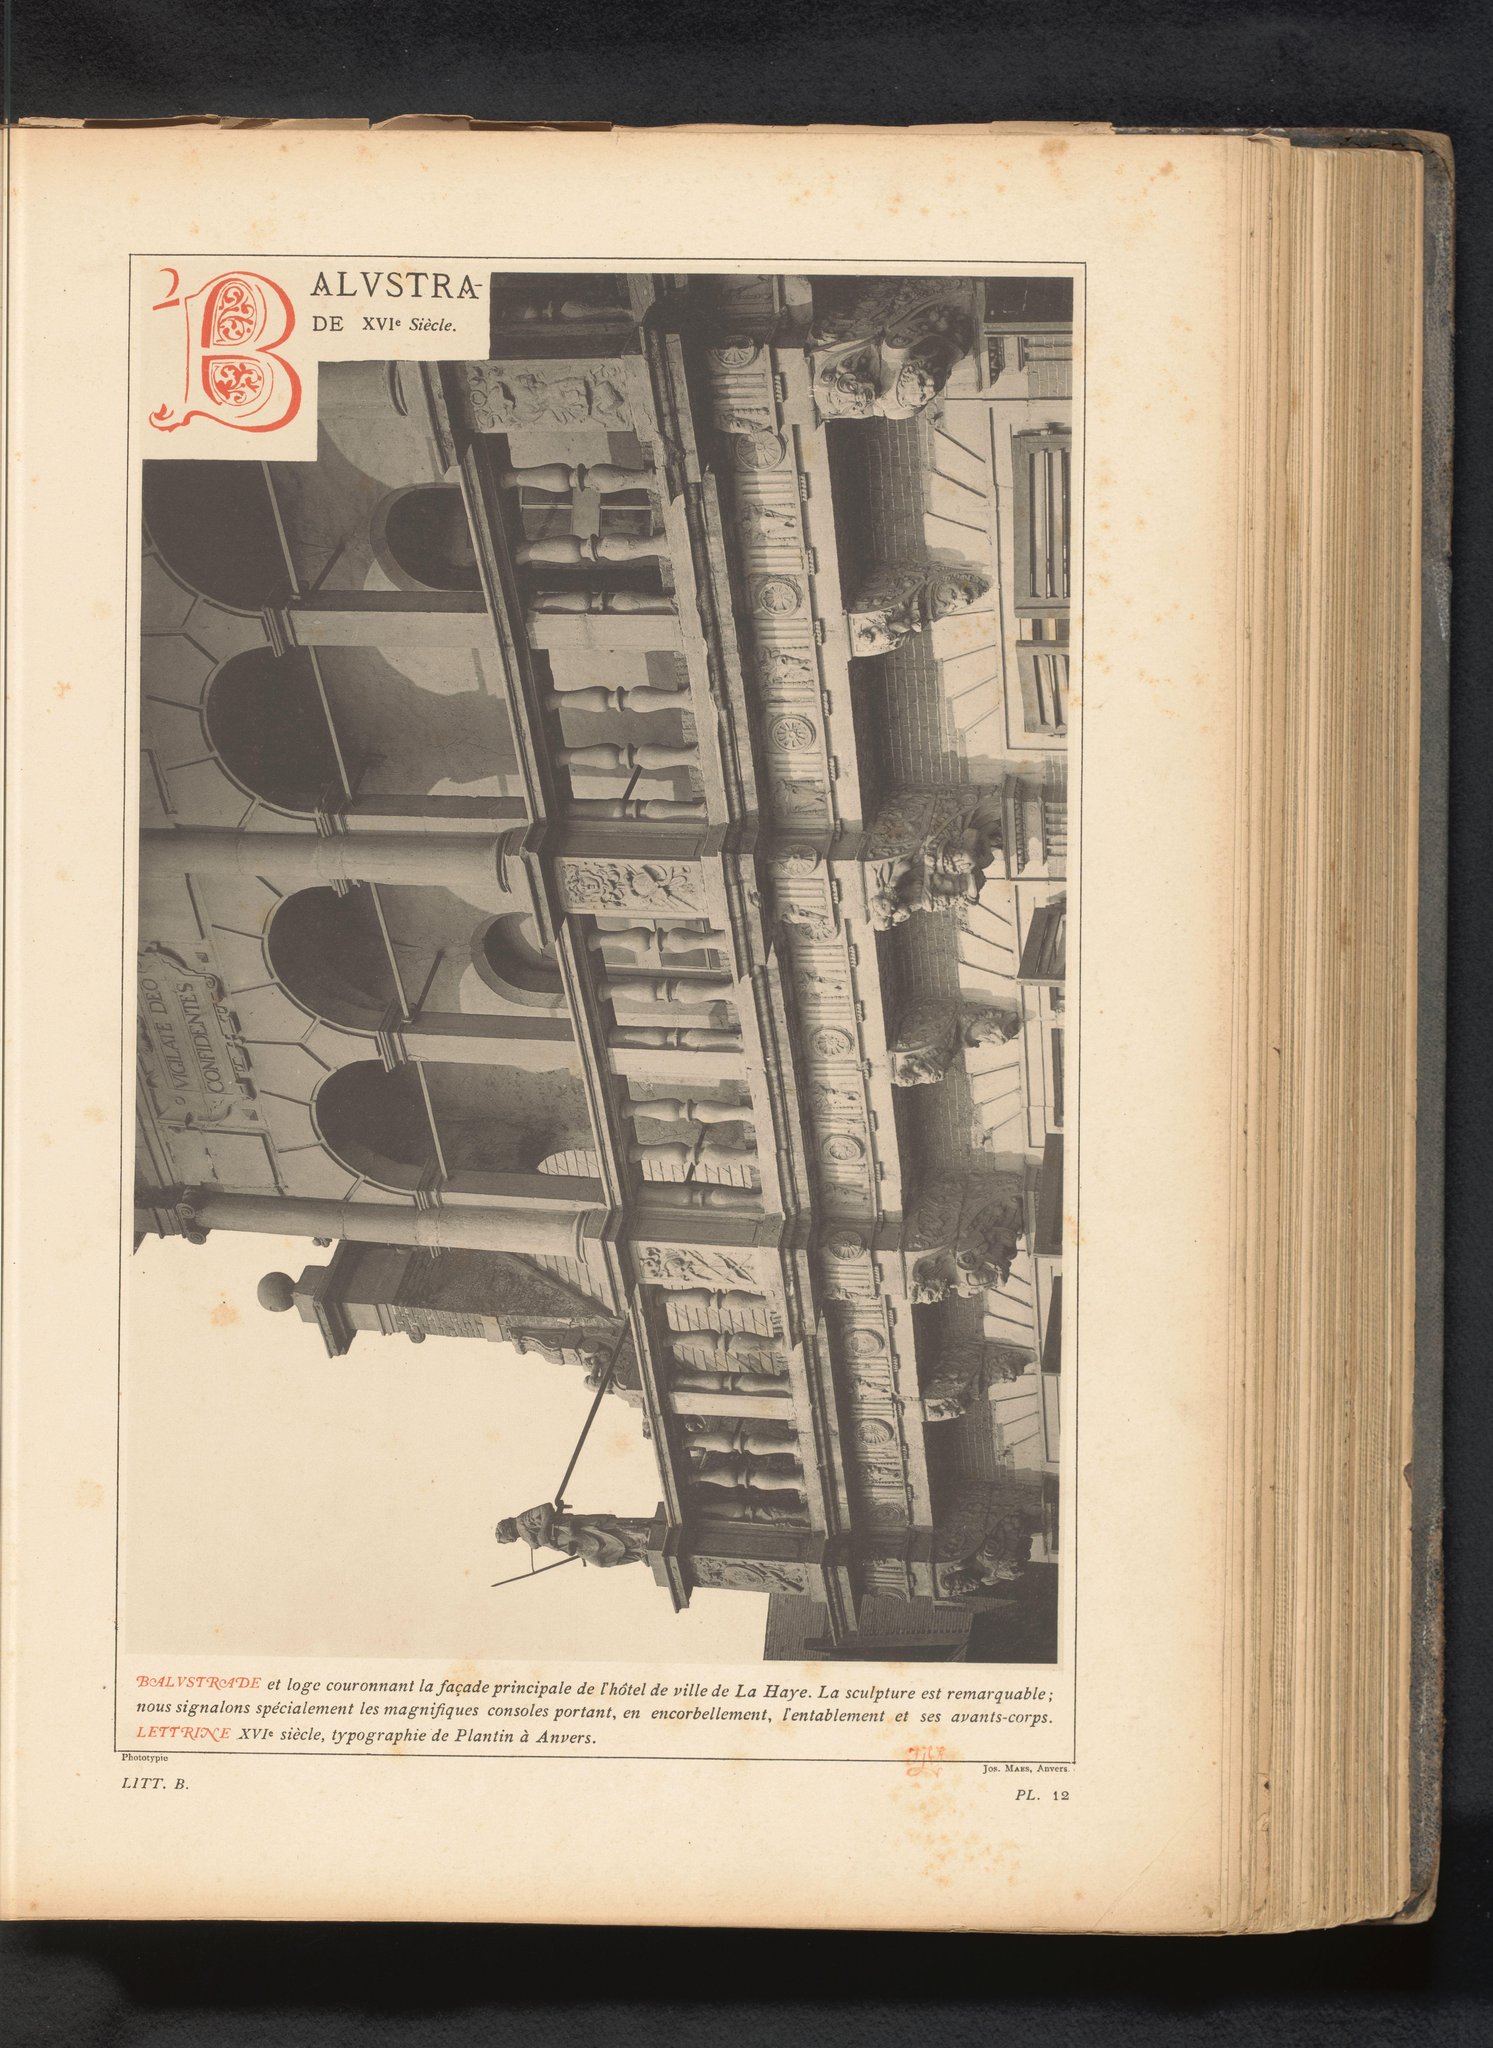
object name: photomechanical print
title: Balustrade van het oude stadhuis van Den Haag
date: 1875-1880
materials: paper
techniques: photograph, photolithography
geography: antwerp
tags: townhall, balcony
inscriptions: inscription: ‘LITT. B. - PL. 12’, monogram: ‘JJvY’, inscription: ‘Balustrade et loge (...)’